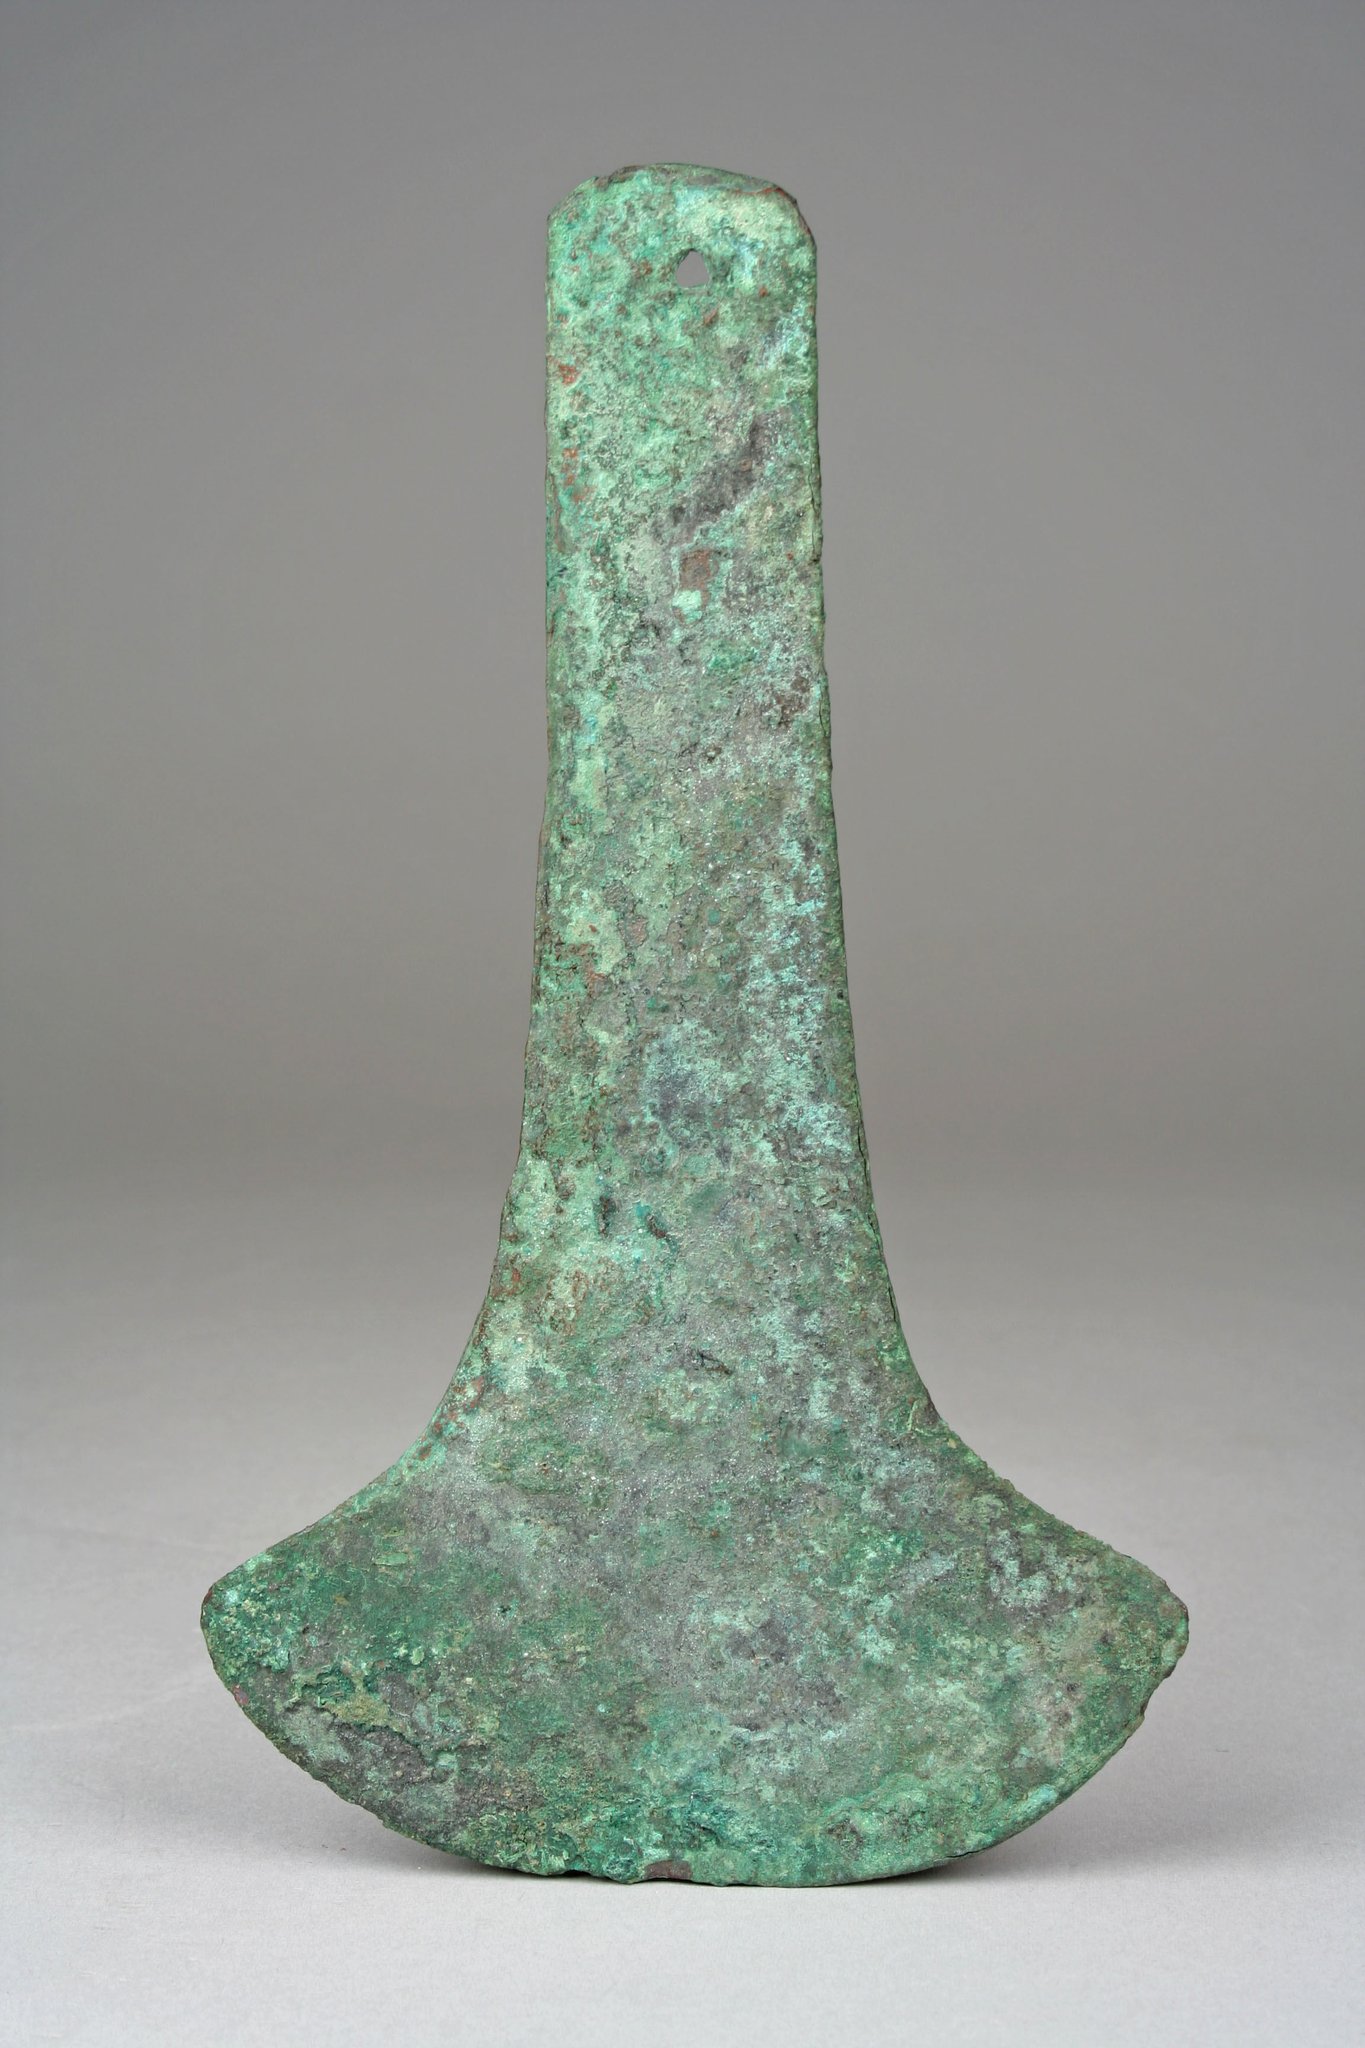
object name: knife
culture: moche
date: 1-766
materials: copper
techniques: hammering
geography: peru